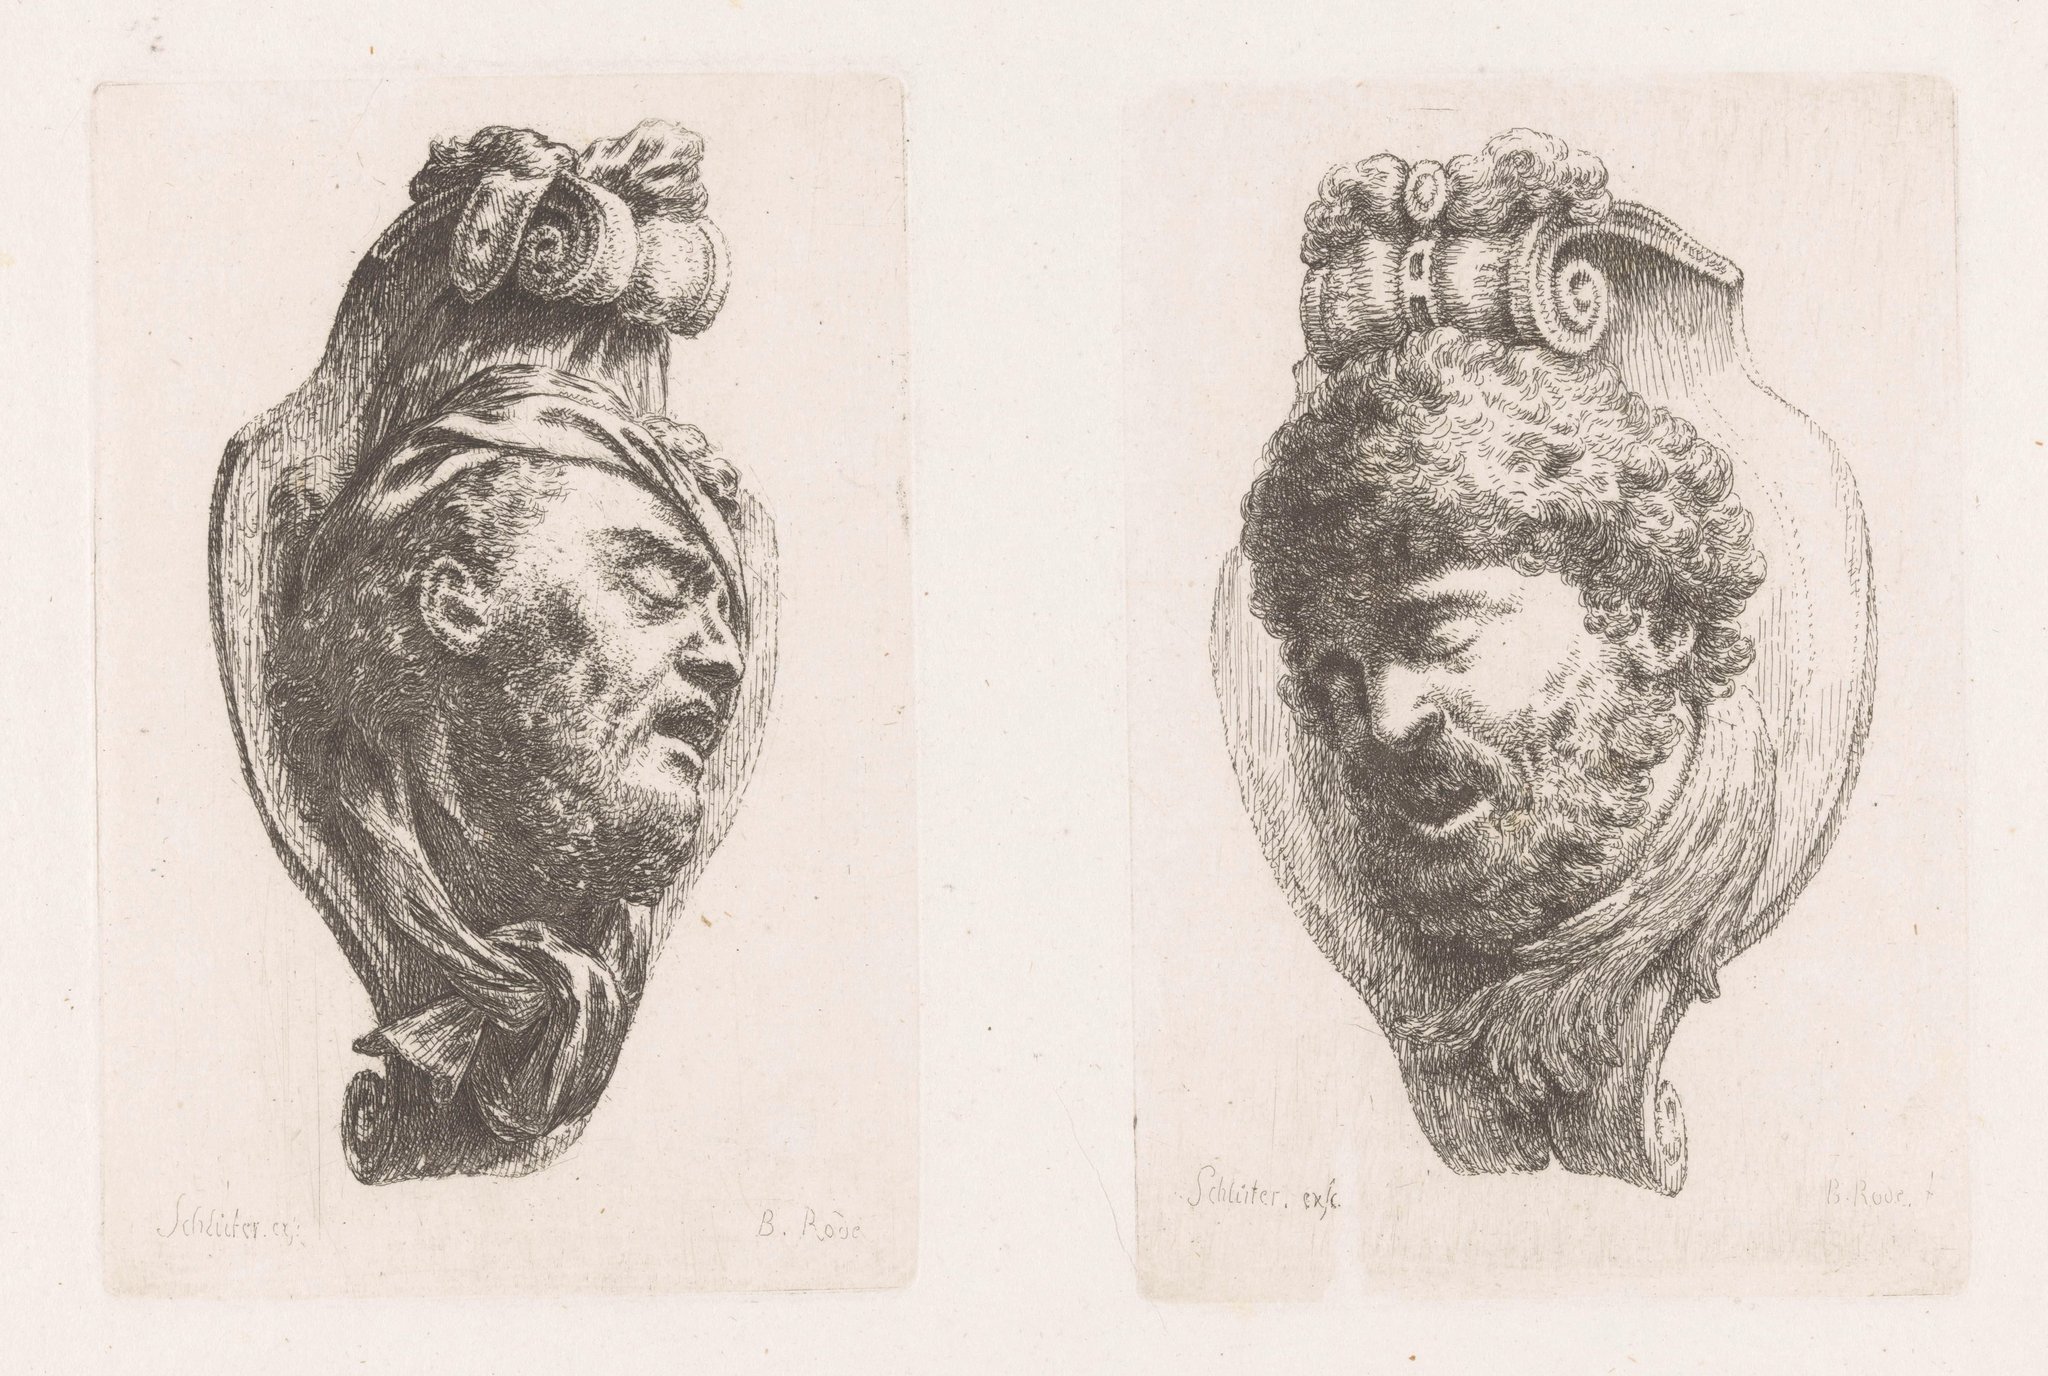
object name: print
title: Mascarons en helmen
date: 1759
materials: paper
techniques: etching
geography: berlin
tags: mask, mascaron ~ ornament, the soldier; the soldier's life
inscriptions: collector's mark: Lugt 2228, collector's mark: Lugt 2760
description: Prent is gemaakt naar de sculpturen van Andreas Schlüter in het Zeughaus (tegenwoordig het Deutsches Historisches Museum) te Berlijn. Mogelijk prent uit: Rode, Bernhard. Larven nach den Modelen des berühmten Schlüters gezeichnet und in Kupfer geätzt von B. Rode. Berlijn: Rode, Heinrich, 1759.